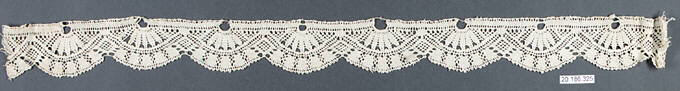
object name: edging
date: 1701-1800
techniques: lace